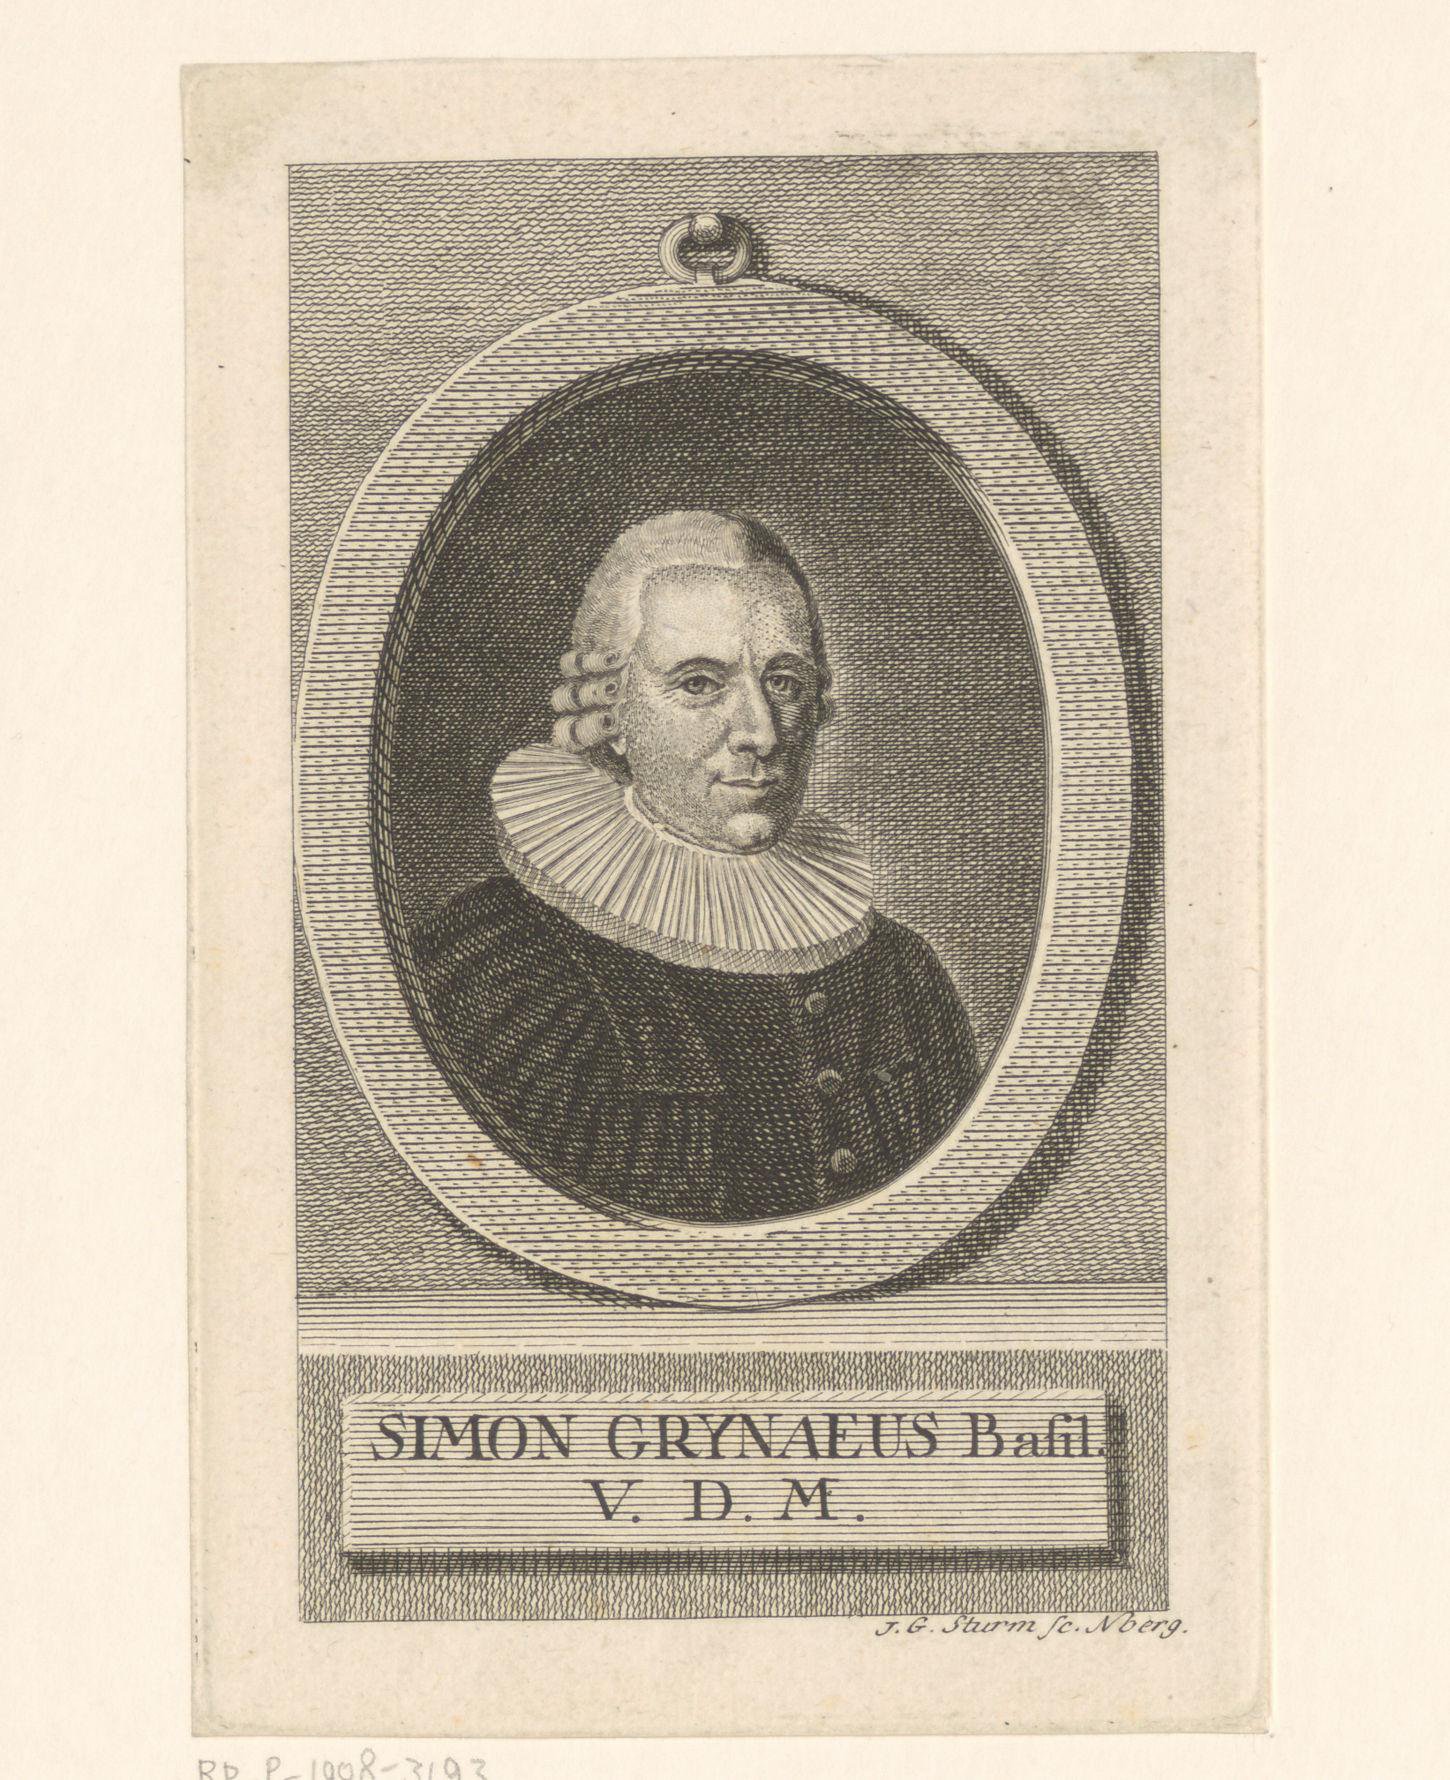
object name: print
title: Portret van Simon Grynäus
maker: johann georg sturm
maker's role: print maker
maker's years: 1742-1793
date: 1752-1793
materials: paper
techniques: engraving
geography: nuremberg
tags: historical persons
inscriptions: collector's mark: Lugt 2228